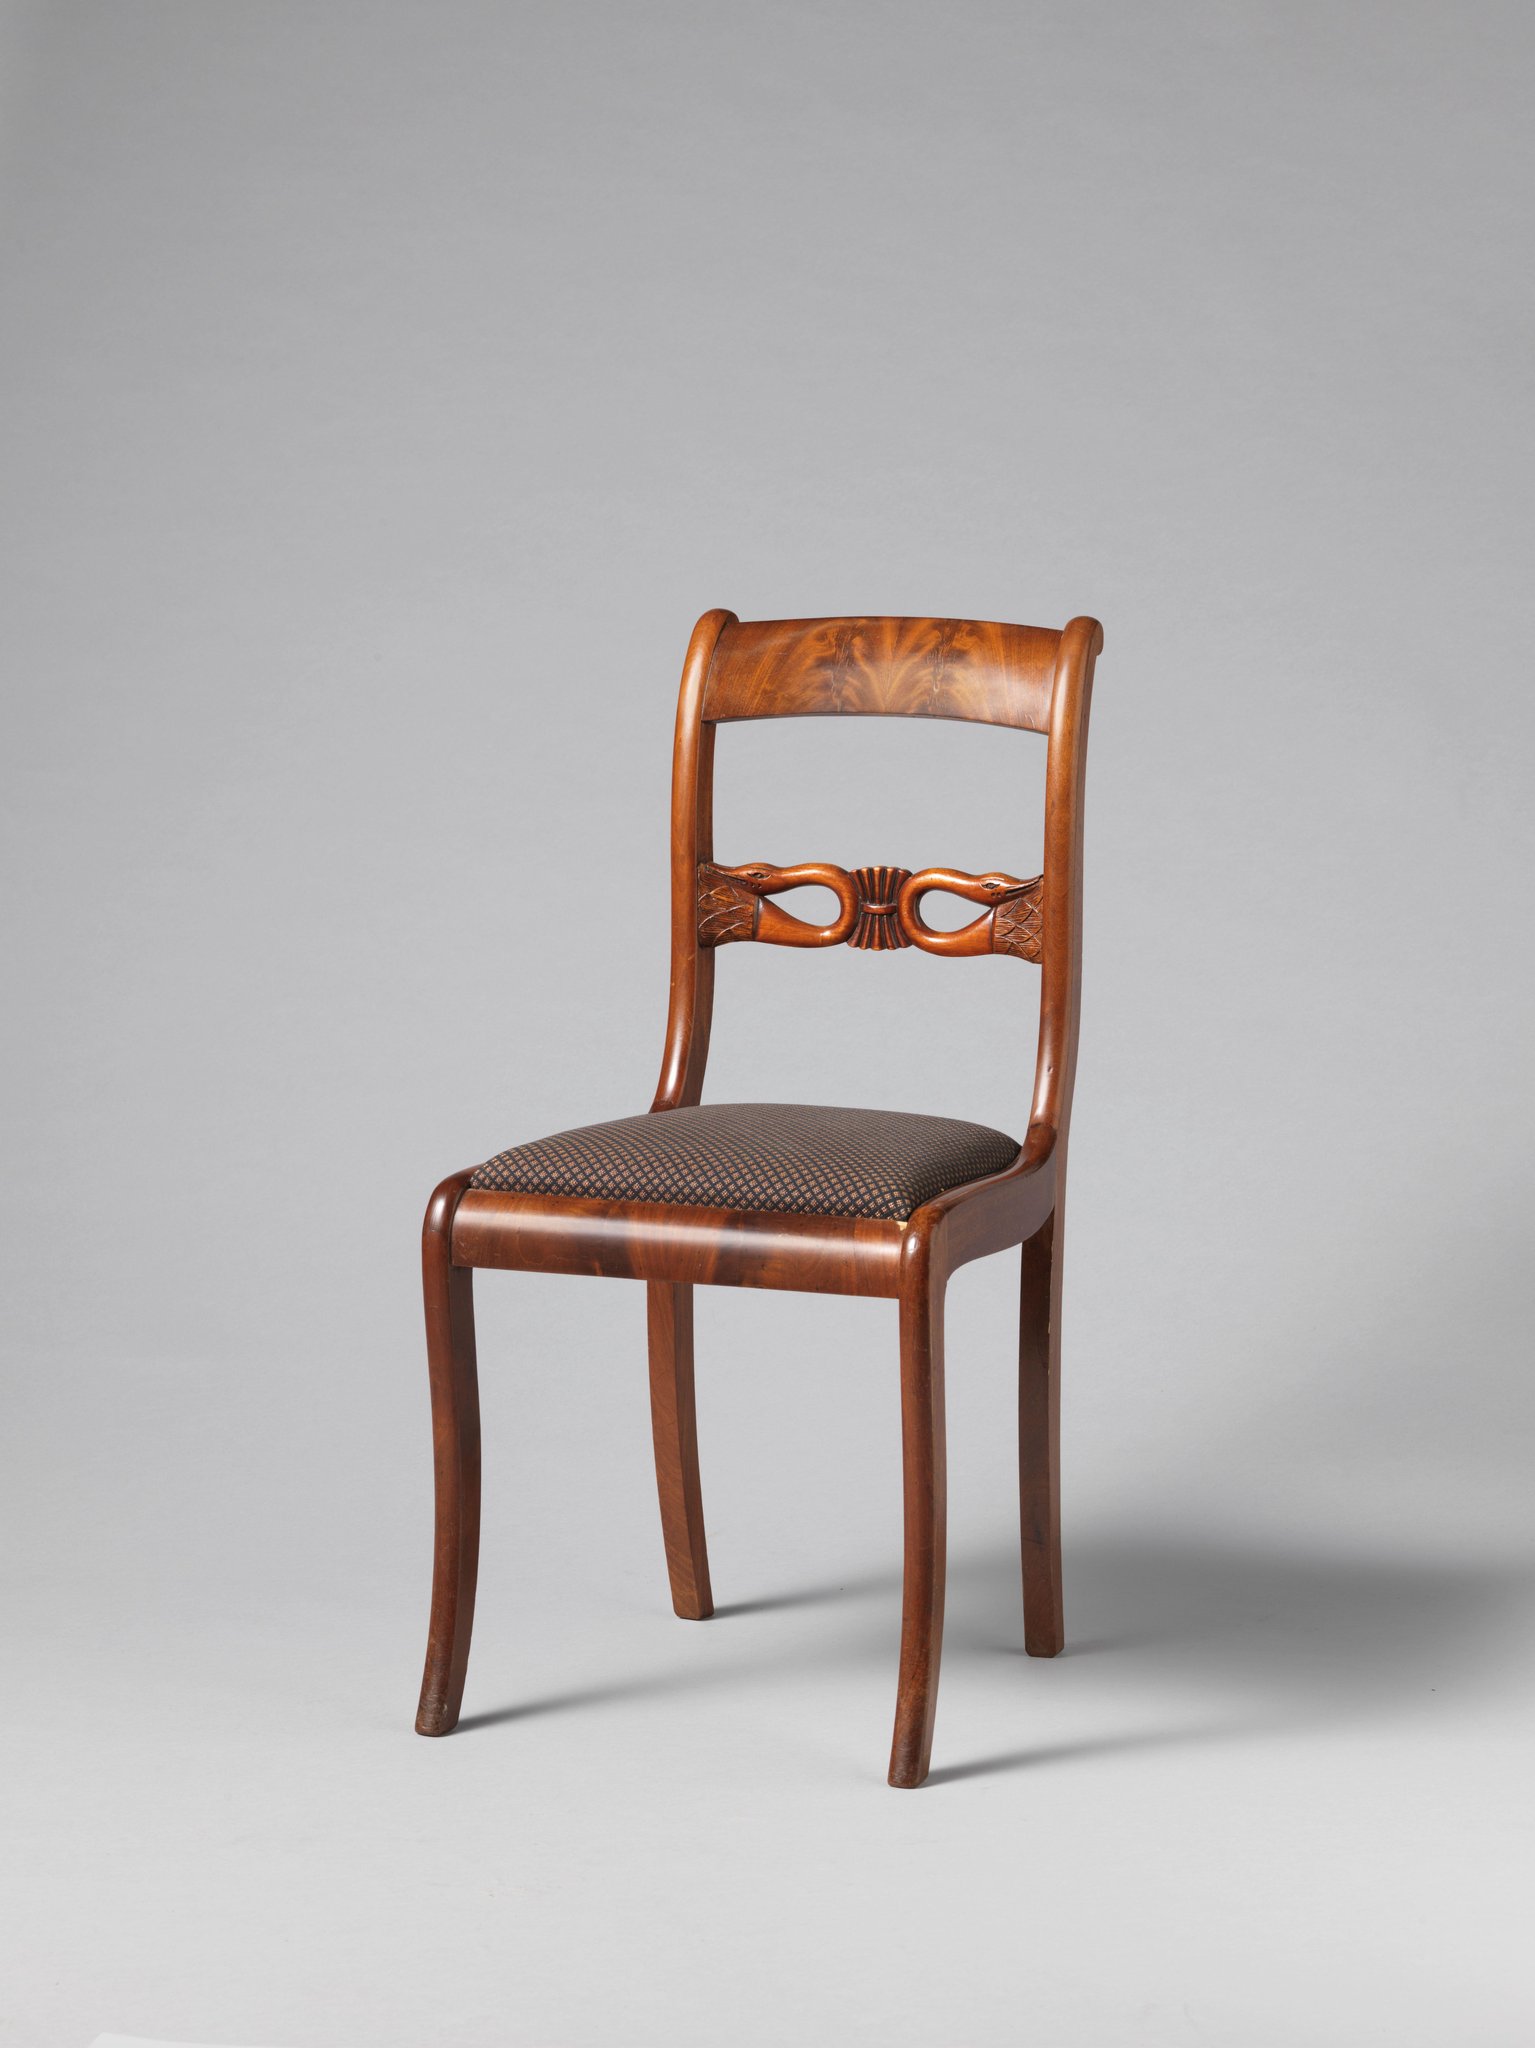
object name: suite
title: Stoel met zwanen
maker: Anonymous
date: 1830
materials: wood, textile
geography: northern netherlands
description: Stoel uit een set van tien stoelen en vier armstoelen van deels massief en deels belijmd mahoniehout op iepenhouten kern. Losse beklede zittingen. De vierkante achterpoten wijken achterwaarts. Negen stoelen en een armstoel hebben vierkante, aan de voorzijde iets afgeronde, voorpoten; de rest heeft ronde gelede voorpoten. De gestrekt S-vormige ruggen hebben een gebeeldhouwde tussenregel met een palmet geflankeerd door twee toegewende, met de halzen terugbuigende zwanen. De platte voluutvormige armleggers lopen hoog in de rug over.